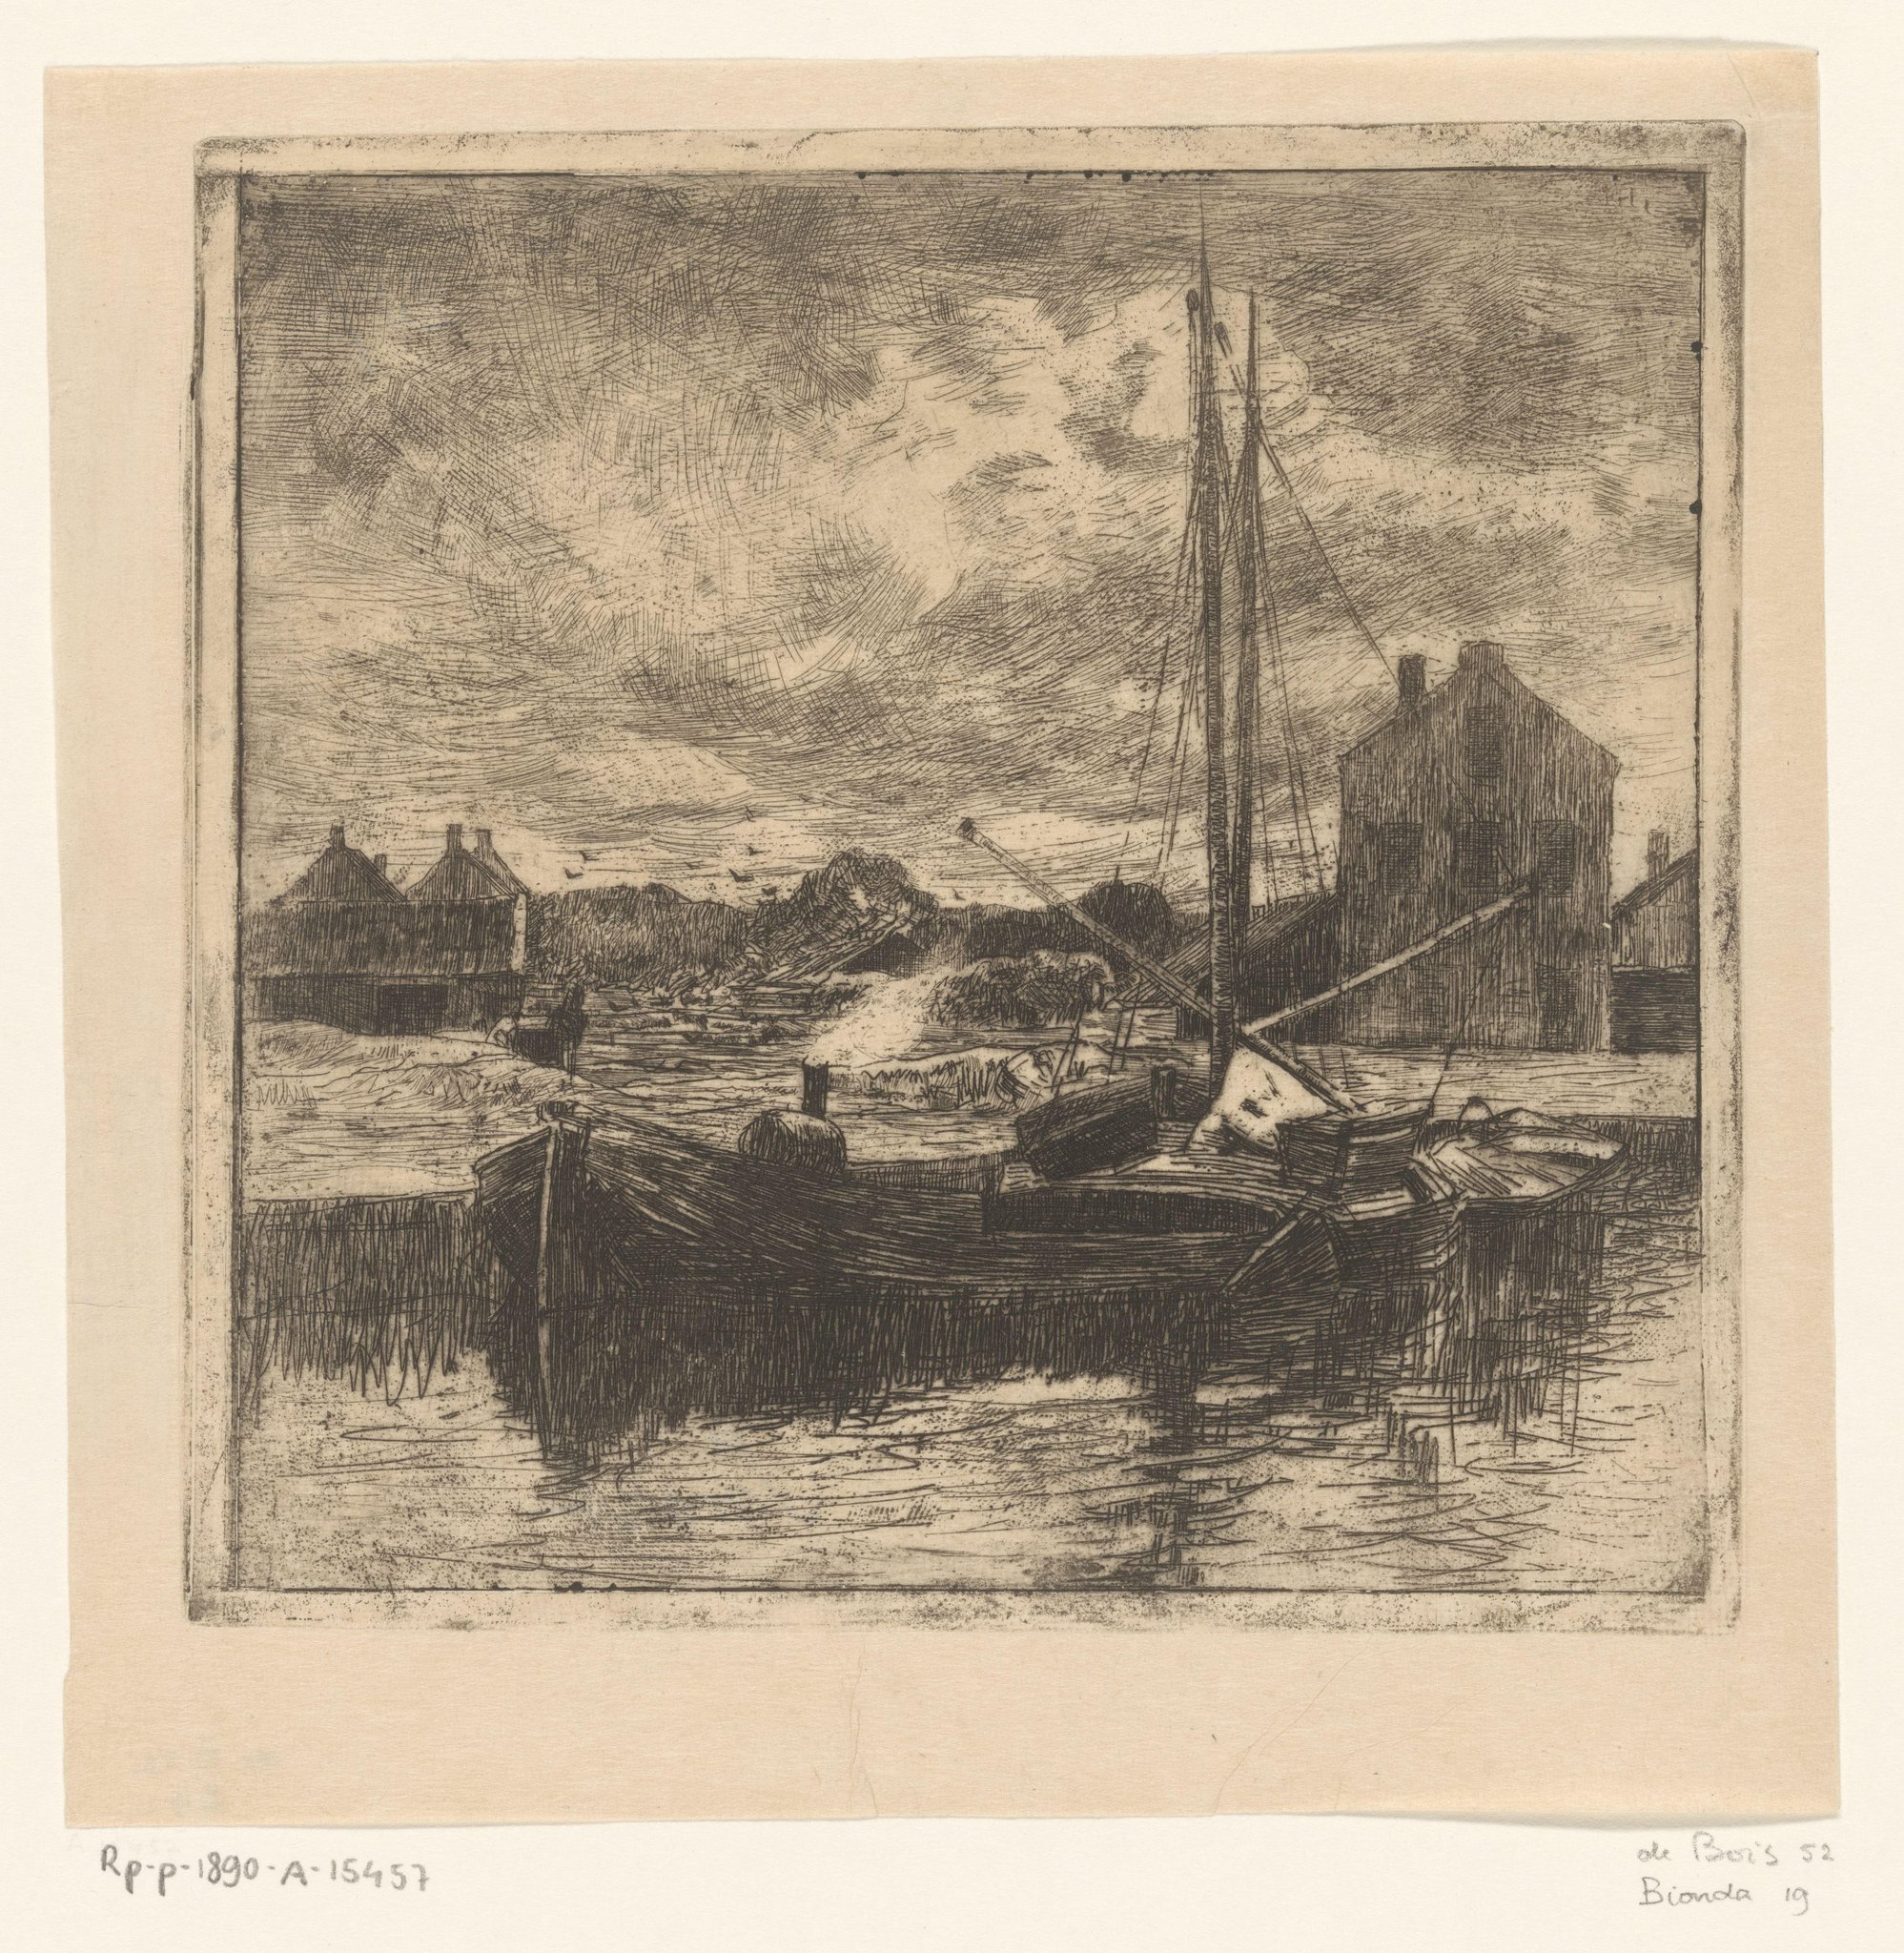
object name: print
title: Losplaats bij pakhuizen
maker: willem de zwart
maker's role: draughtsman, painter, print maker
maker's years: 1862-1931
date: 1885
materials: paper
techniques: drypoint, etching, intaglio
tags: warehouse (~ harbour), sailing-ship, sailing-boat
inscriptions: collector's mark: Lugt 2228